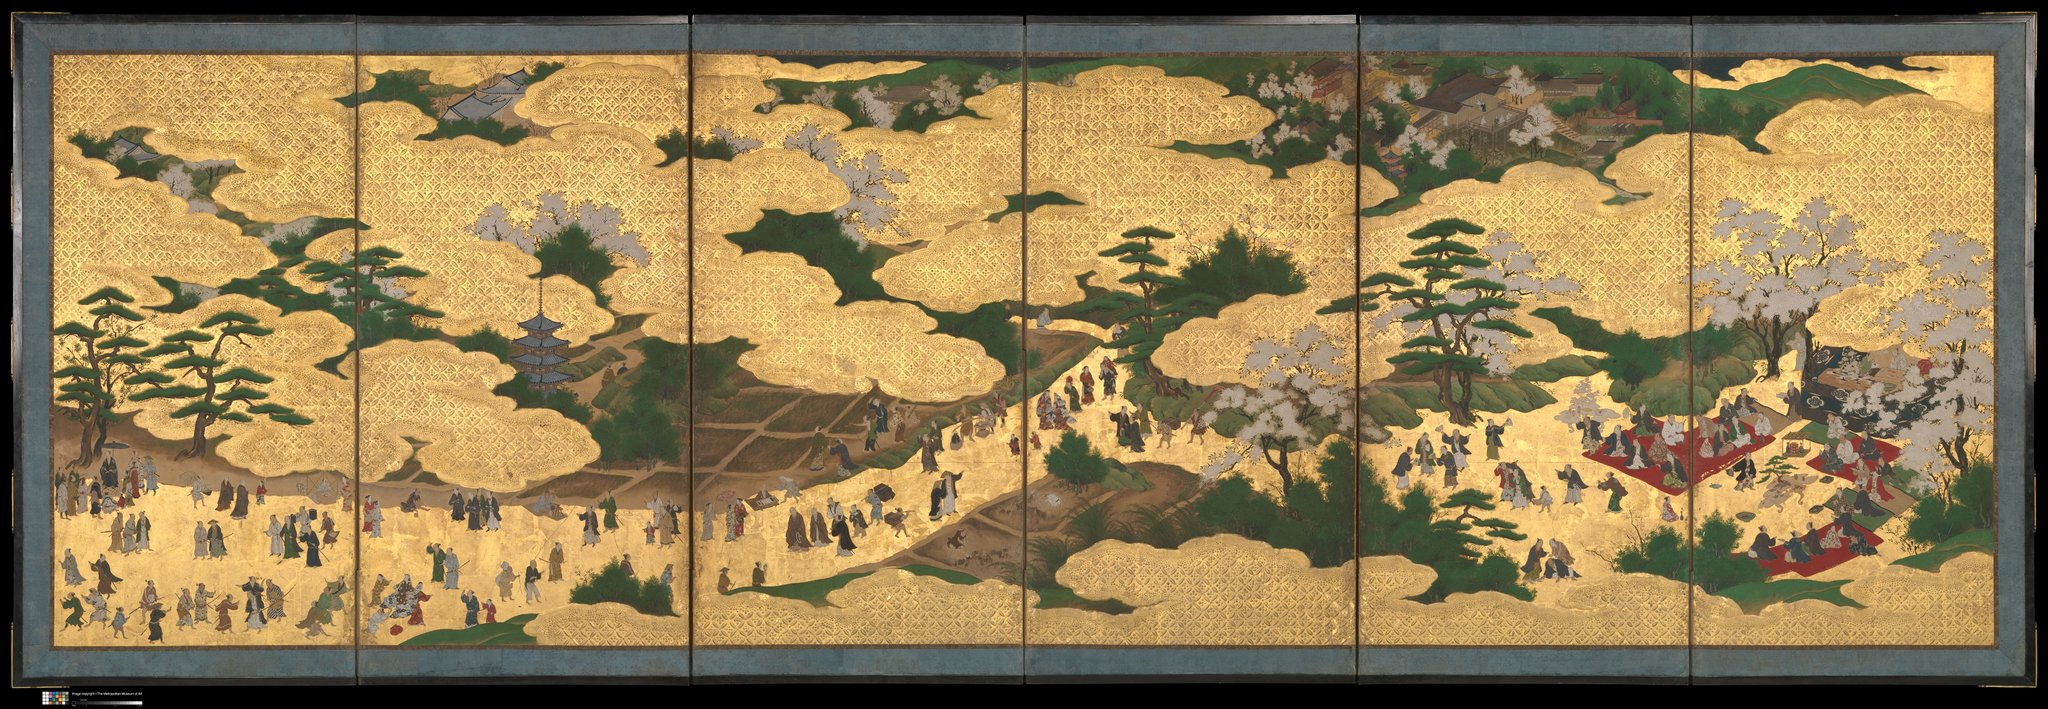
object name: screen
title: Amusements at Higashiyama in Kyoto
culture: japanese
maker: kano school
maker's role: artist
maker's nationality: japanese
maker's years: 1476-1559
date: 1620-1629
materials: gold, gold leaf, ink, mica, panel, paper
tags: men,women,banquets